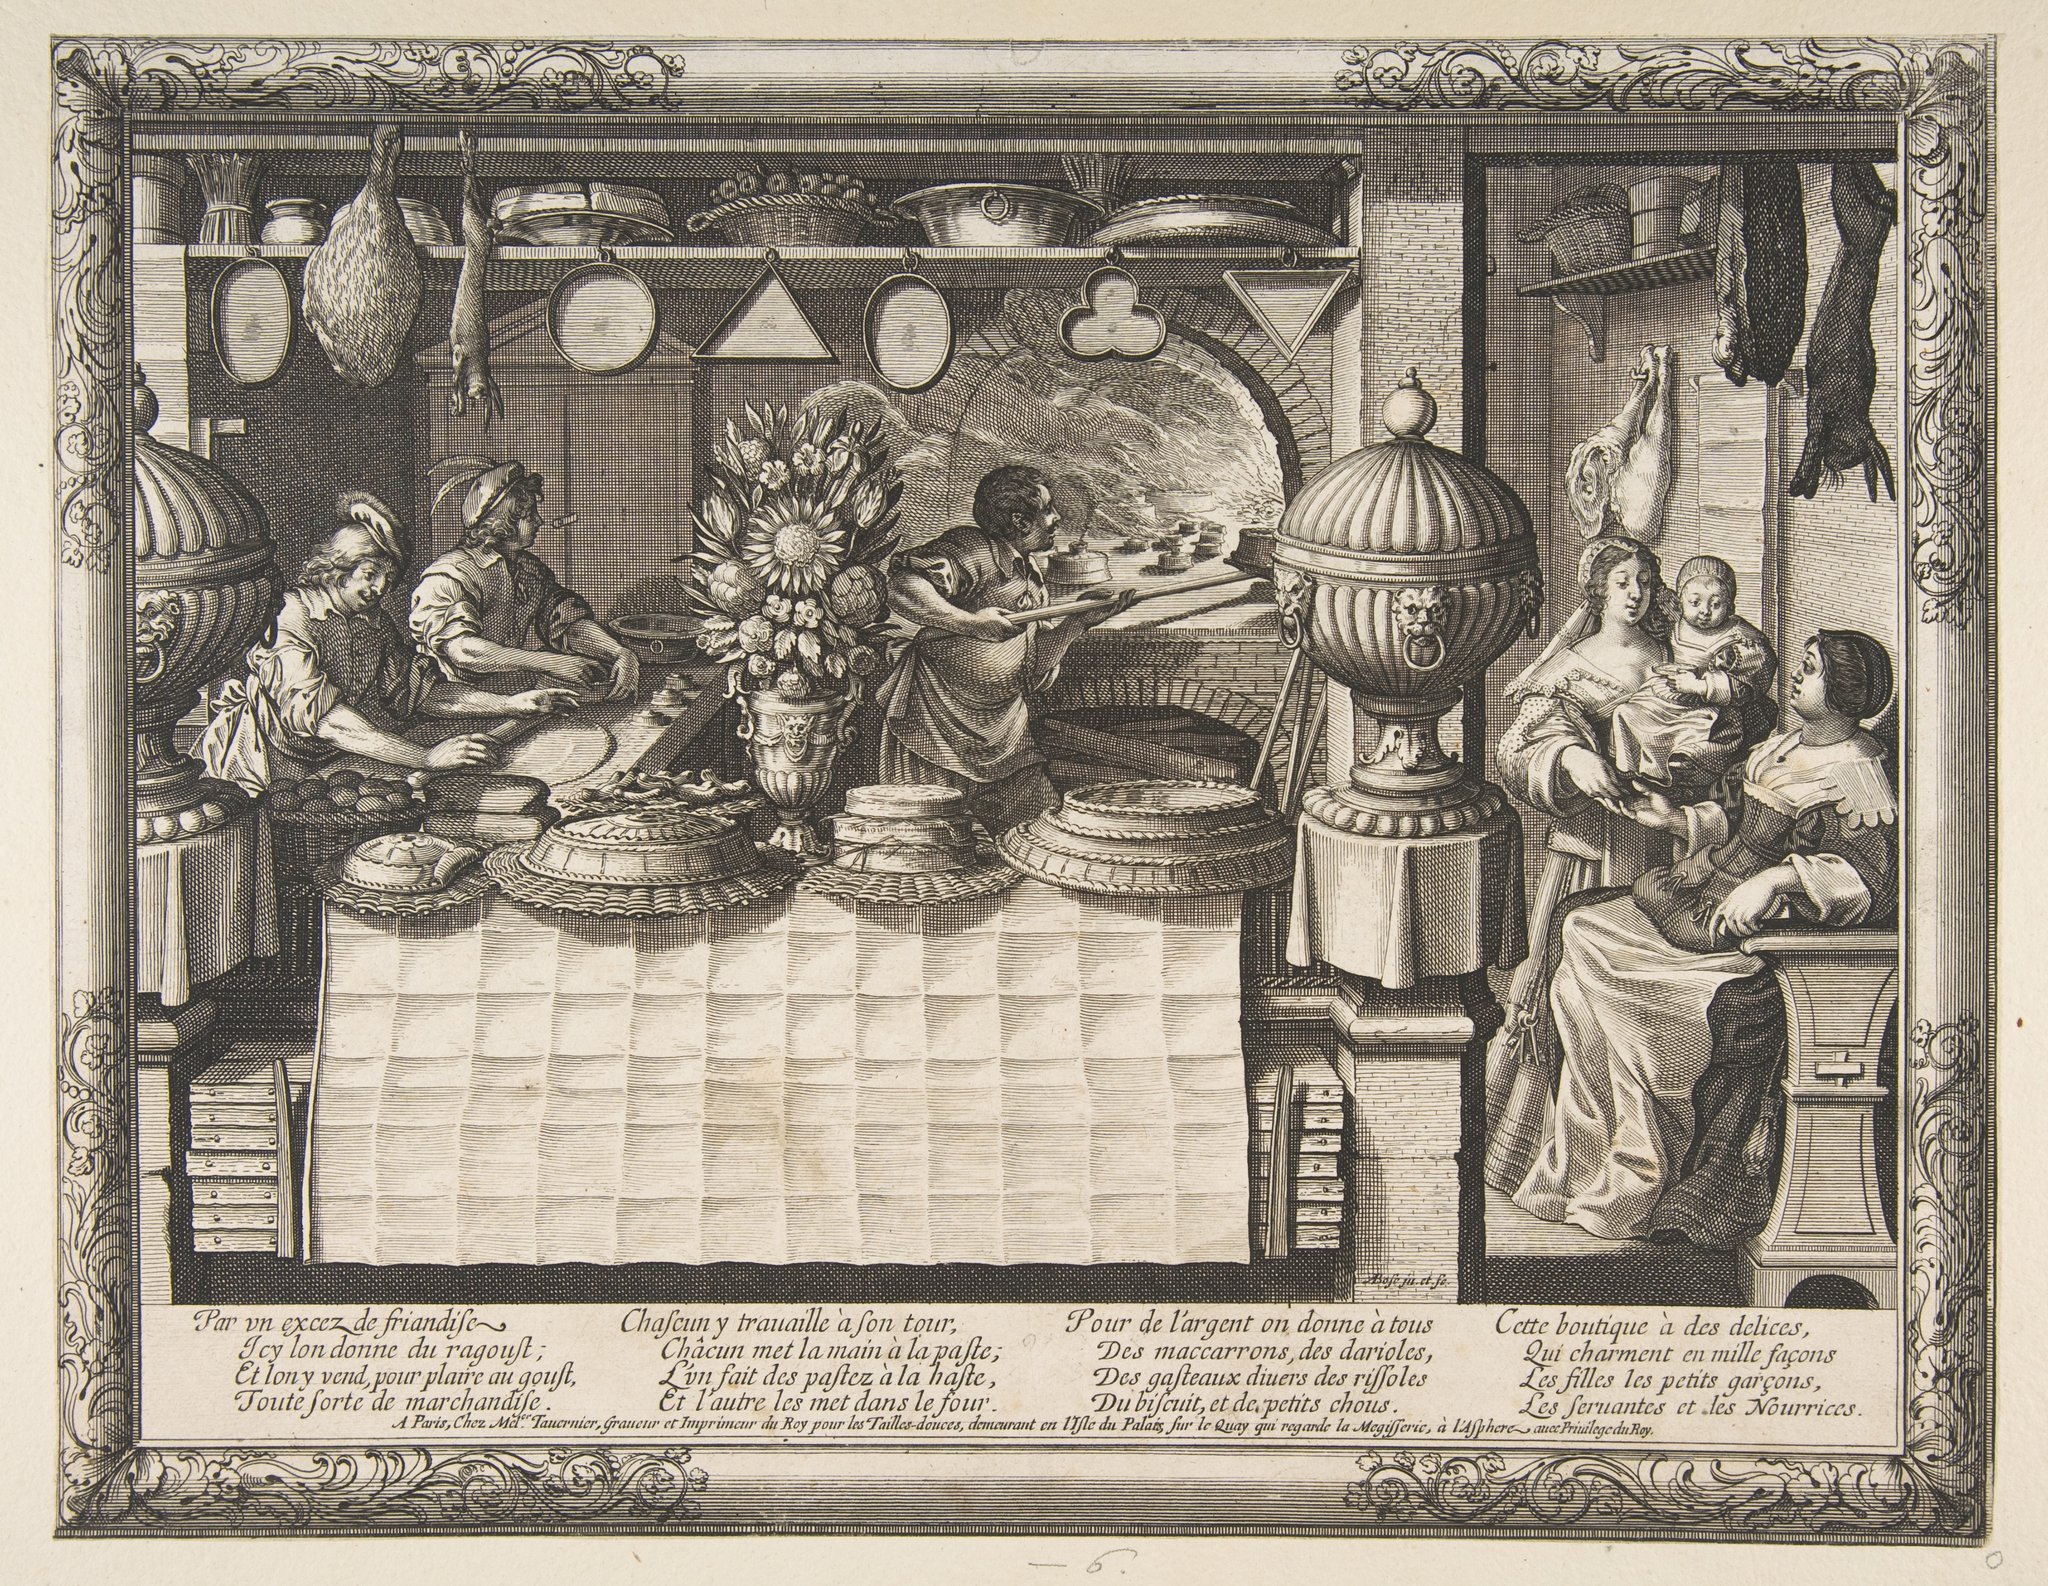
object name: print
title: Pastry Shop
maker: abraham bosse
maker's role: artist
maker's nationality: french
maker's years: 1602-1676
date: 1632-1633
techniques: etching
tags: food,kitchens,men,women,bakers,cooking